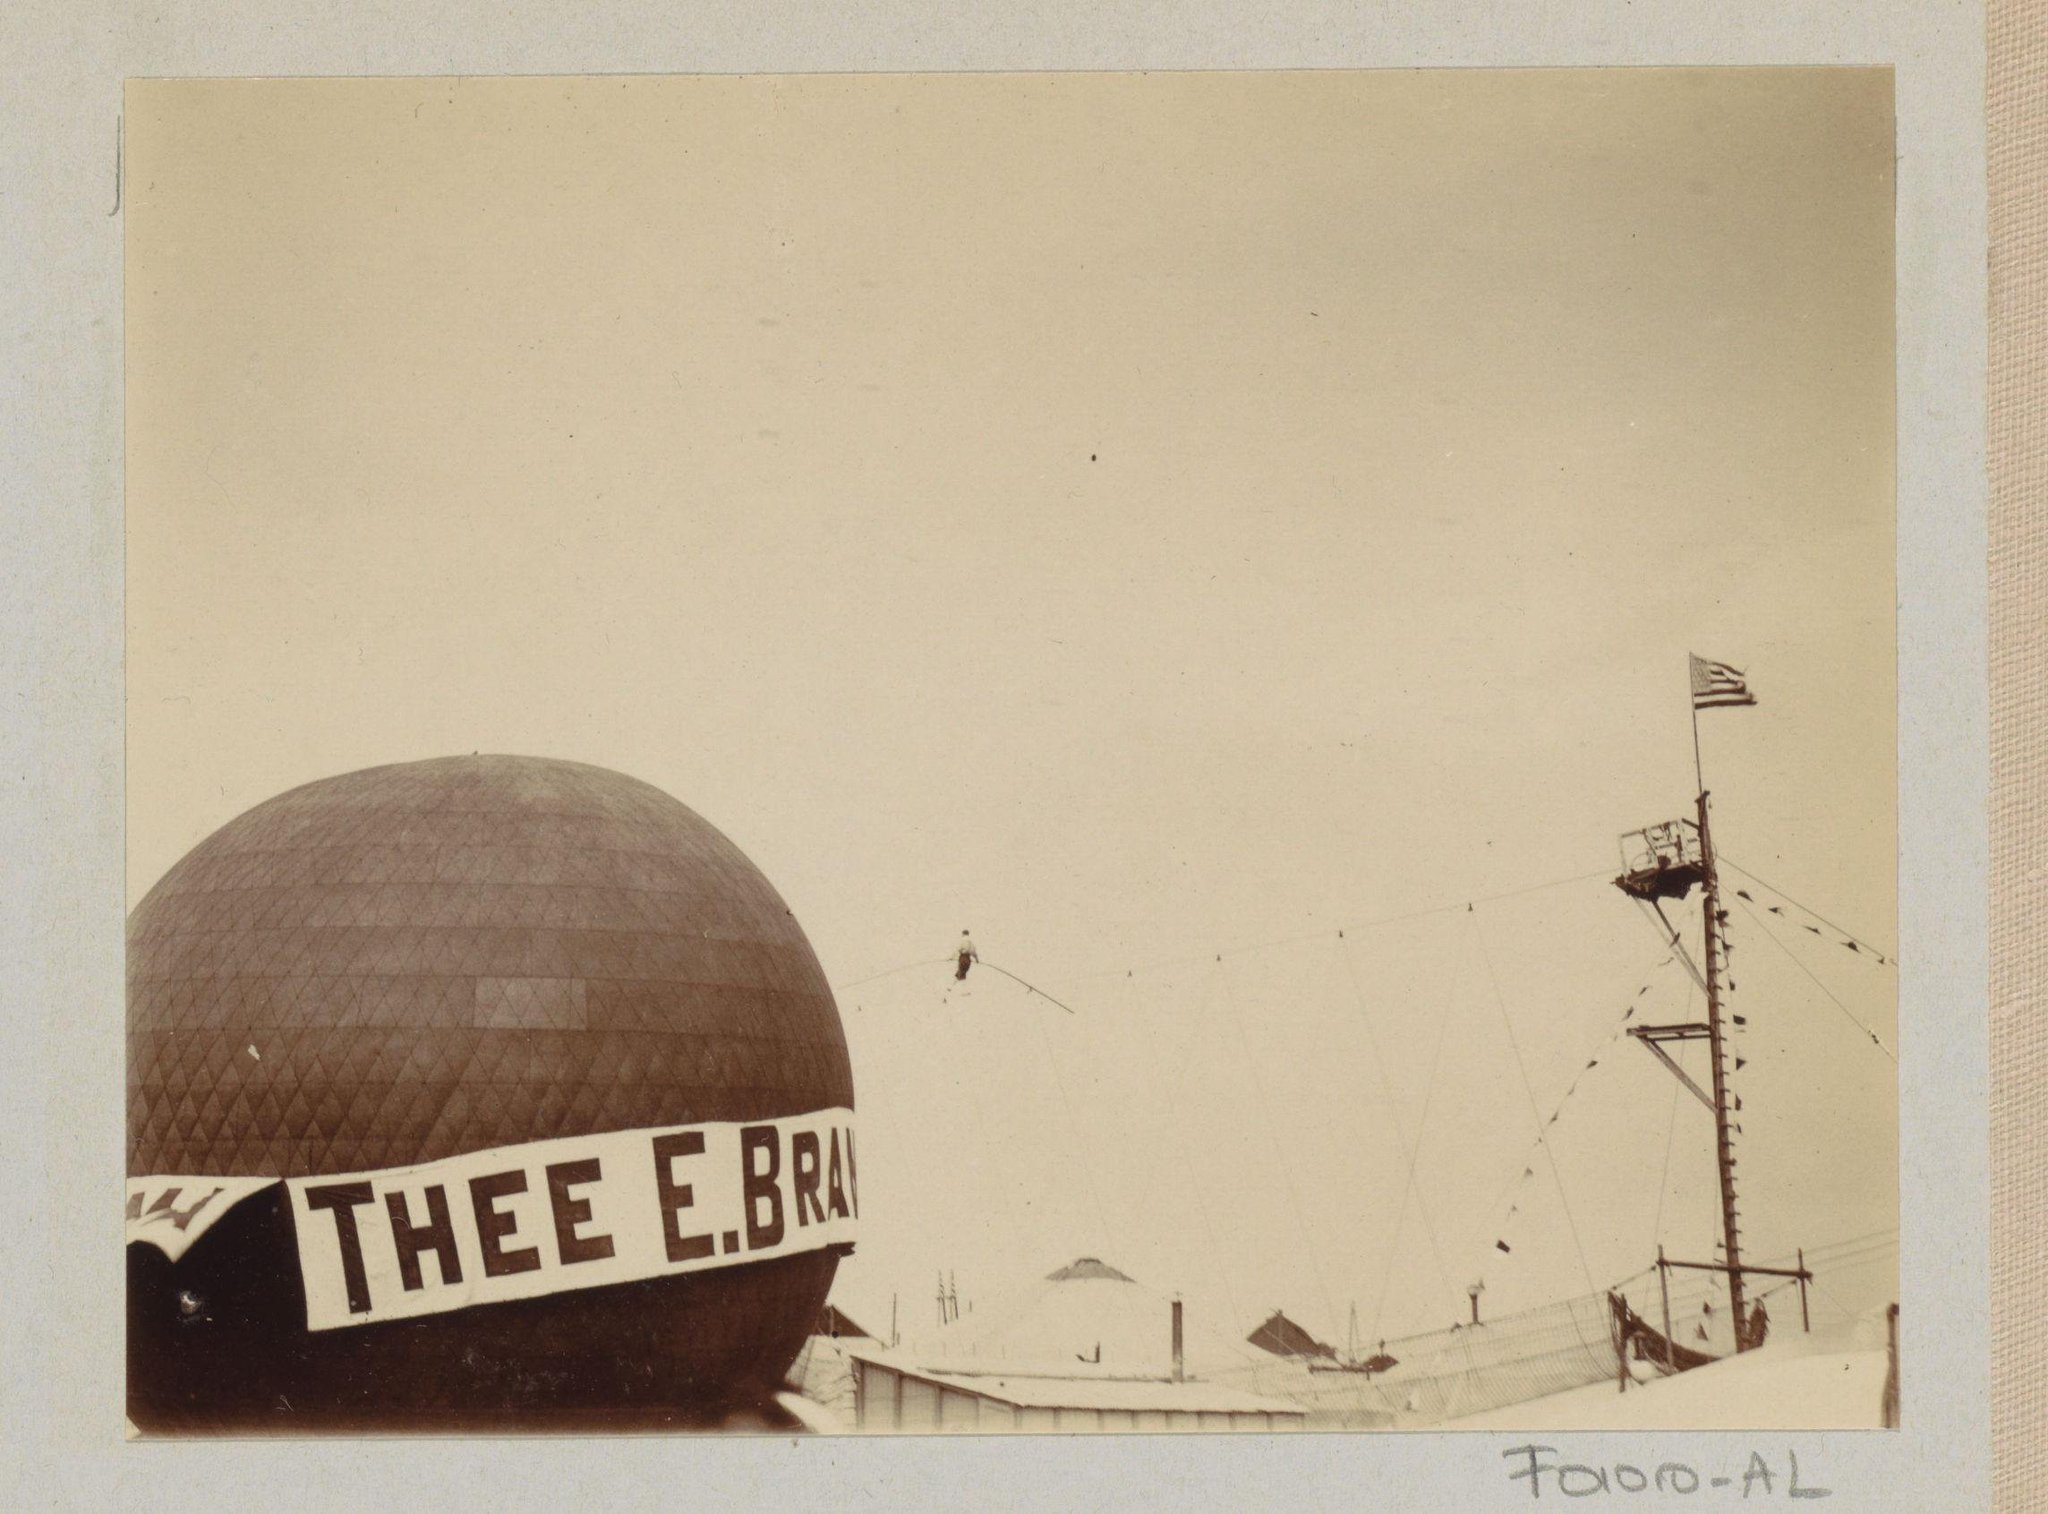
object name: photograph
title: Luchtballon met reclame voor 'Thee E. Brandsma', op de achtergrond een koorddanser boven een kermisterrein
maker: Anonymous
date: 1900-1910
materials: photographic support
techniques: daylight paper print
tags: advertising, equilibrist, pleasure fair and circus, balloon (aviation)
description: Onderdeel van Familiealbum met onder meer foto's van Wijnhandel Kraaij & Co. Bordeaux-Amsterdam.